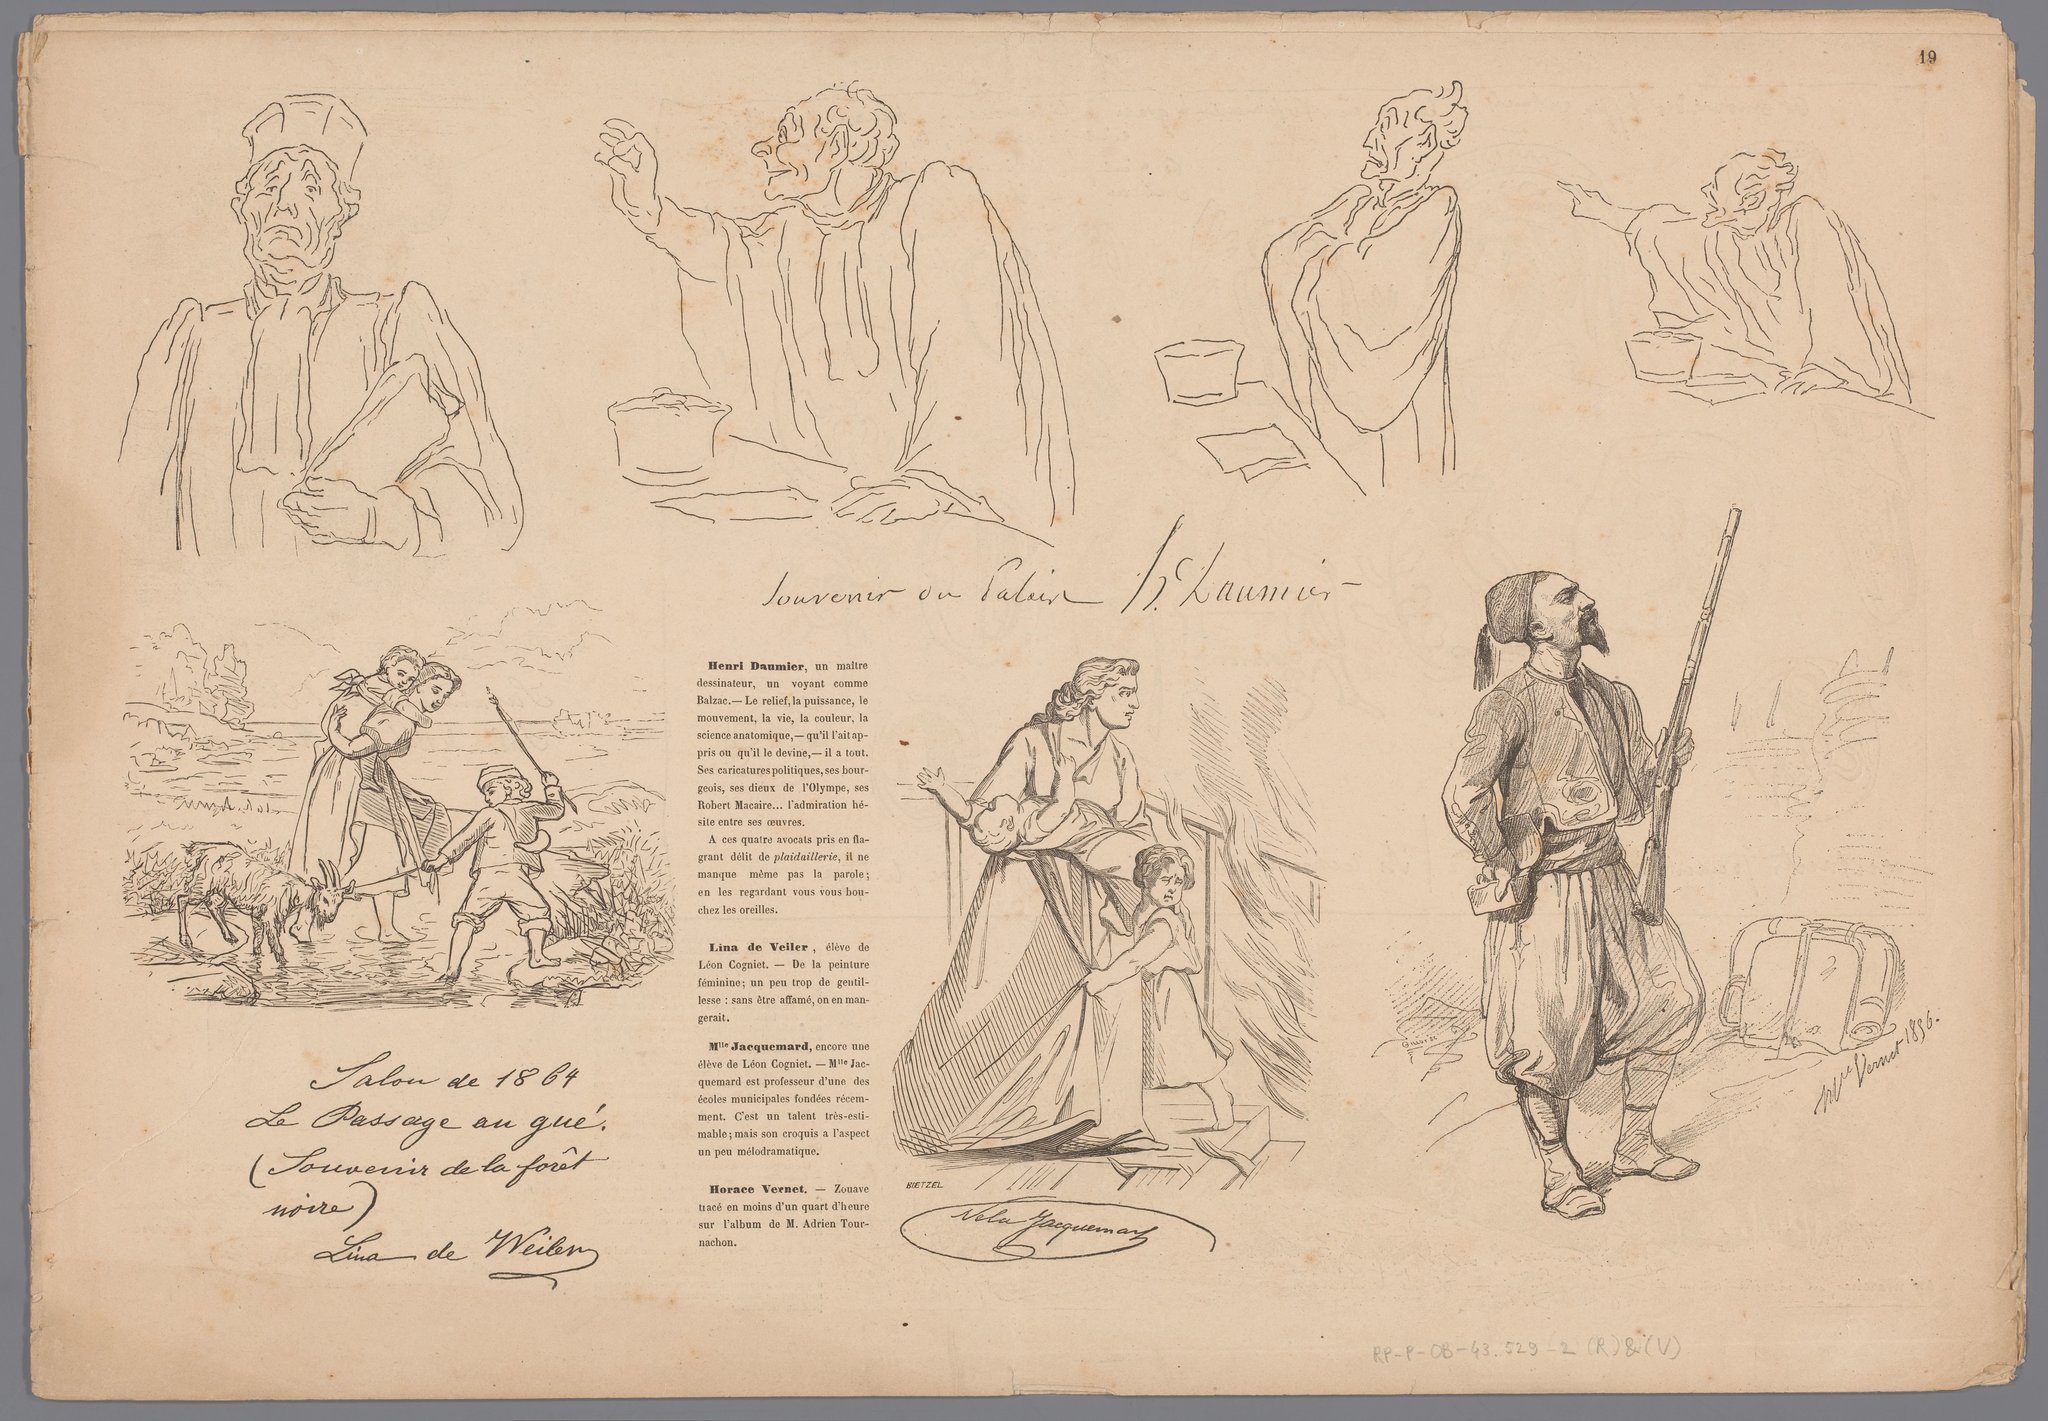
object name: print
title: Vier karikaturen van een man, vrouw met kinderen en een geit, vrouw met kinderen bij een brand en een man met fez en geweer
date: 1864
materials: paper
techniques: gillotage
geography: paris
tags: caricatures (human types), open fire (in general), firearms: rifle, mother and child(ren), woman and child(ren) (family group)